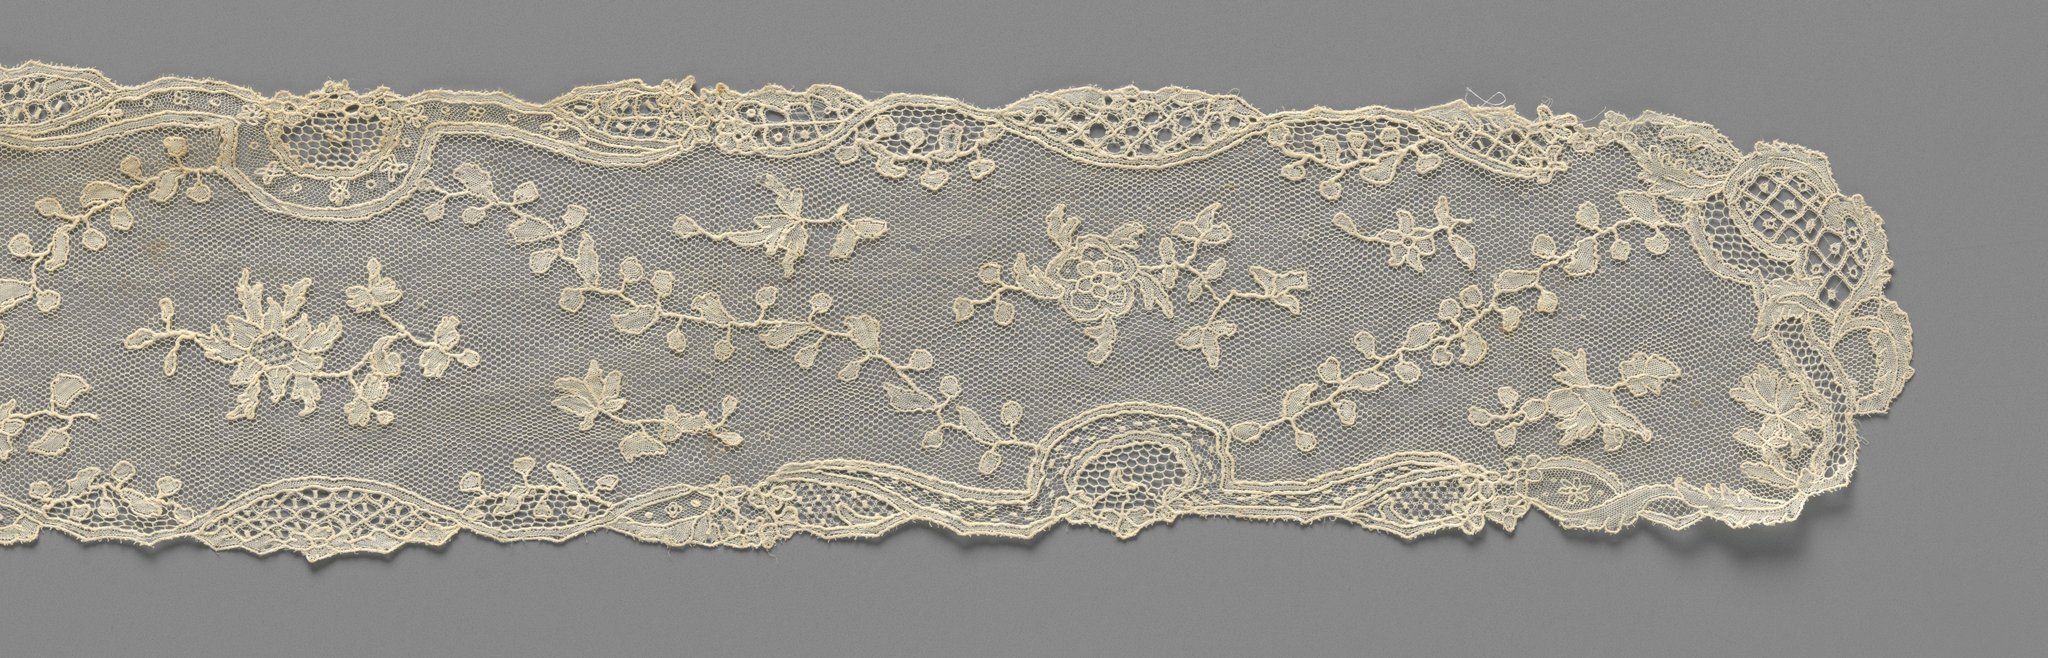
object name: lappet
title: Mutsenslip van applicatiekant met drie éénbloemige takken in de velden tussen een golvende bladertak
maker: Anonymous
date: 1770-1780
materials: linen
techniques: lace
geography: brussels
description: Mutsenslip van naturelkleurige applicatiekant: naaldkant geappliceerd op drochelgrond. Het patroon heeft langs de rand medaillons met verschillende vormen en met diverse vullingen. In het middenveld een golvende tak met kleine bladeren. In de ruimtes tussen de rand en de slingerende tak staan drie losse bloemtakken, steeds met één bloem per tak. De bloemen verschillen van elkaar en de bloem aan de middelste tak is het grootst. De motieven zijn opgebouwd uit festonsteken en voorzien van reliëfcontouren. Ze zijn met elkaar verbonden door een fijne gekloste traliegrond, een drochelgrond. De vlakke schulpenrand komt voort uit het patroon met de medaillons en is afgewerkt met picots. De schulpenrand loopt door in één afgerond uiteinde. Het andere uiteinde is recht afgeknipt en onafgewerkt.